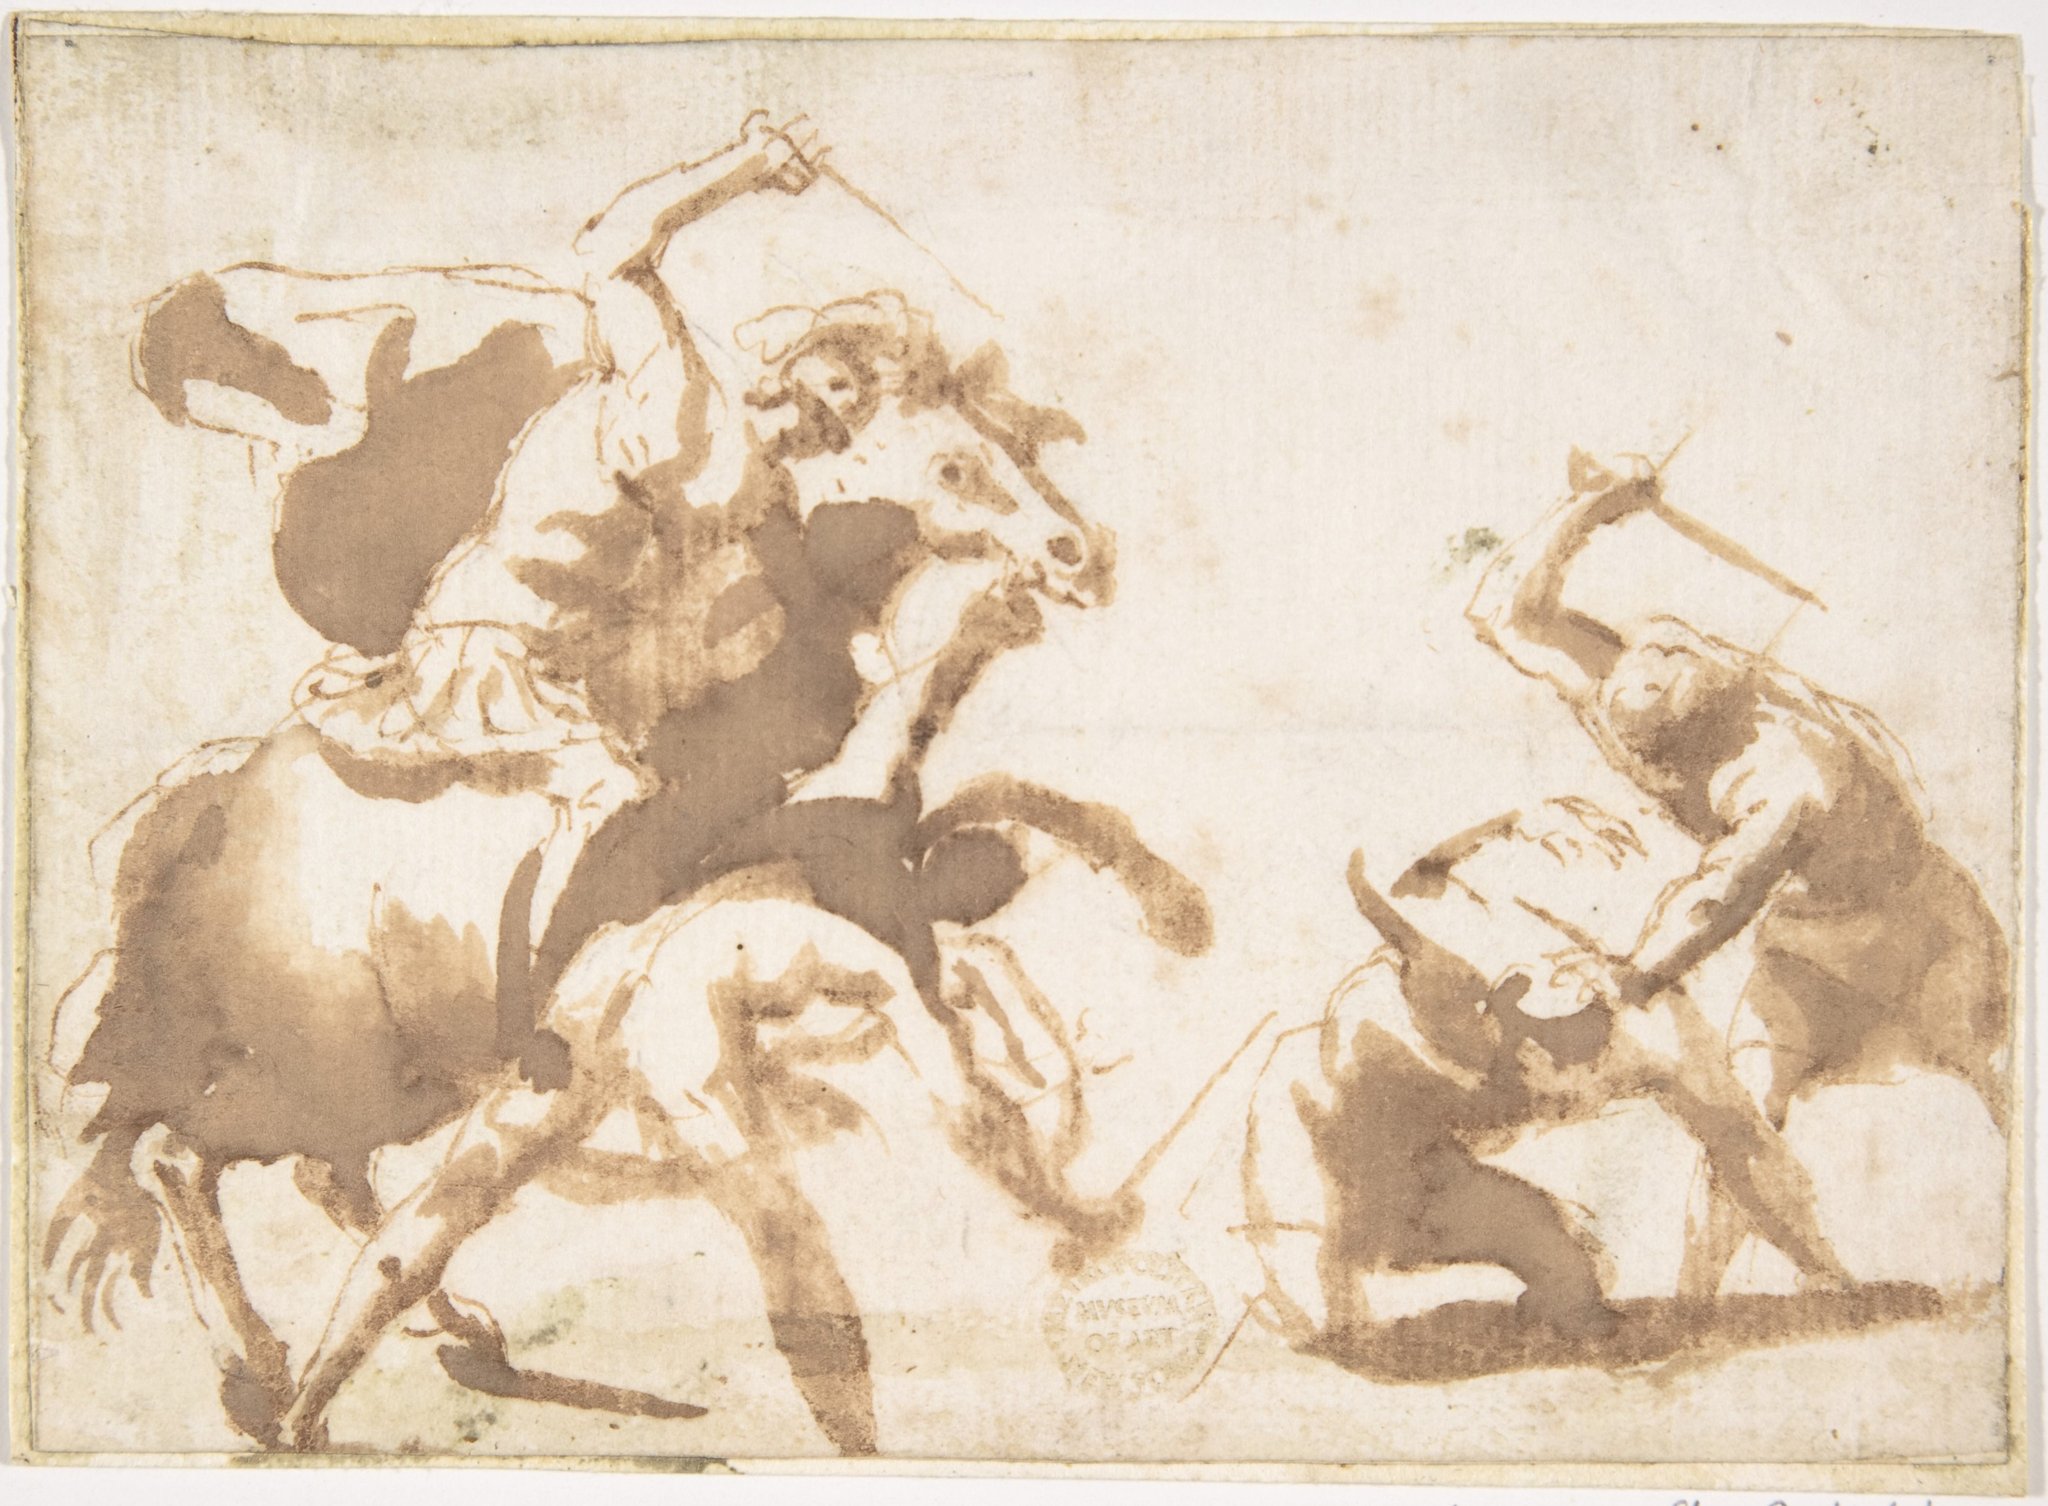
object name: drawing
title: Horsemen and Three Foot Soldiers in Battle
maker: francesco allegrini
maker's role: artist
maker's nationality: italian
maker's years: 1615-1679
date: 1624-1663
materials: ink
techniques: brush, pen, wash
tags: battles,soldiers,weapons,men,horses